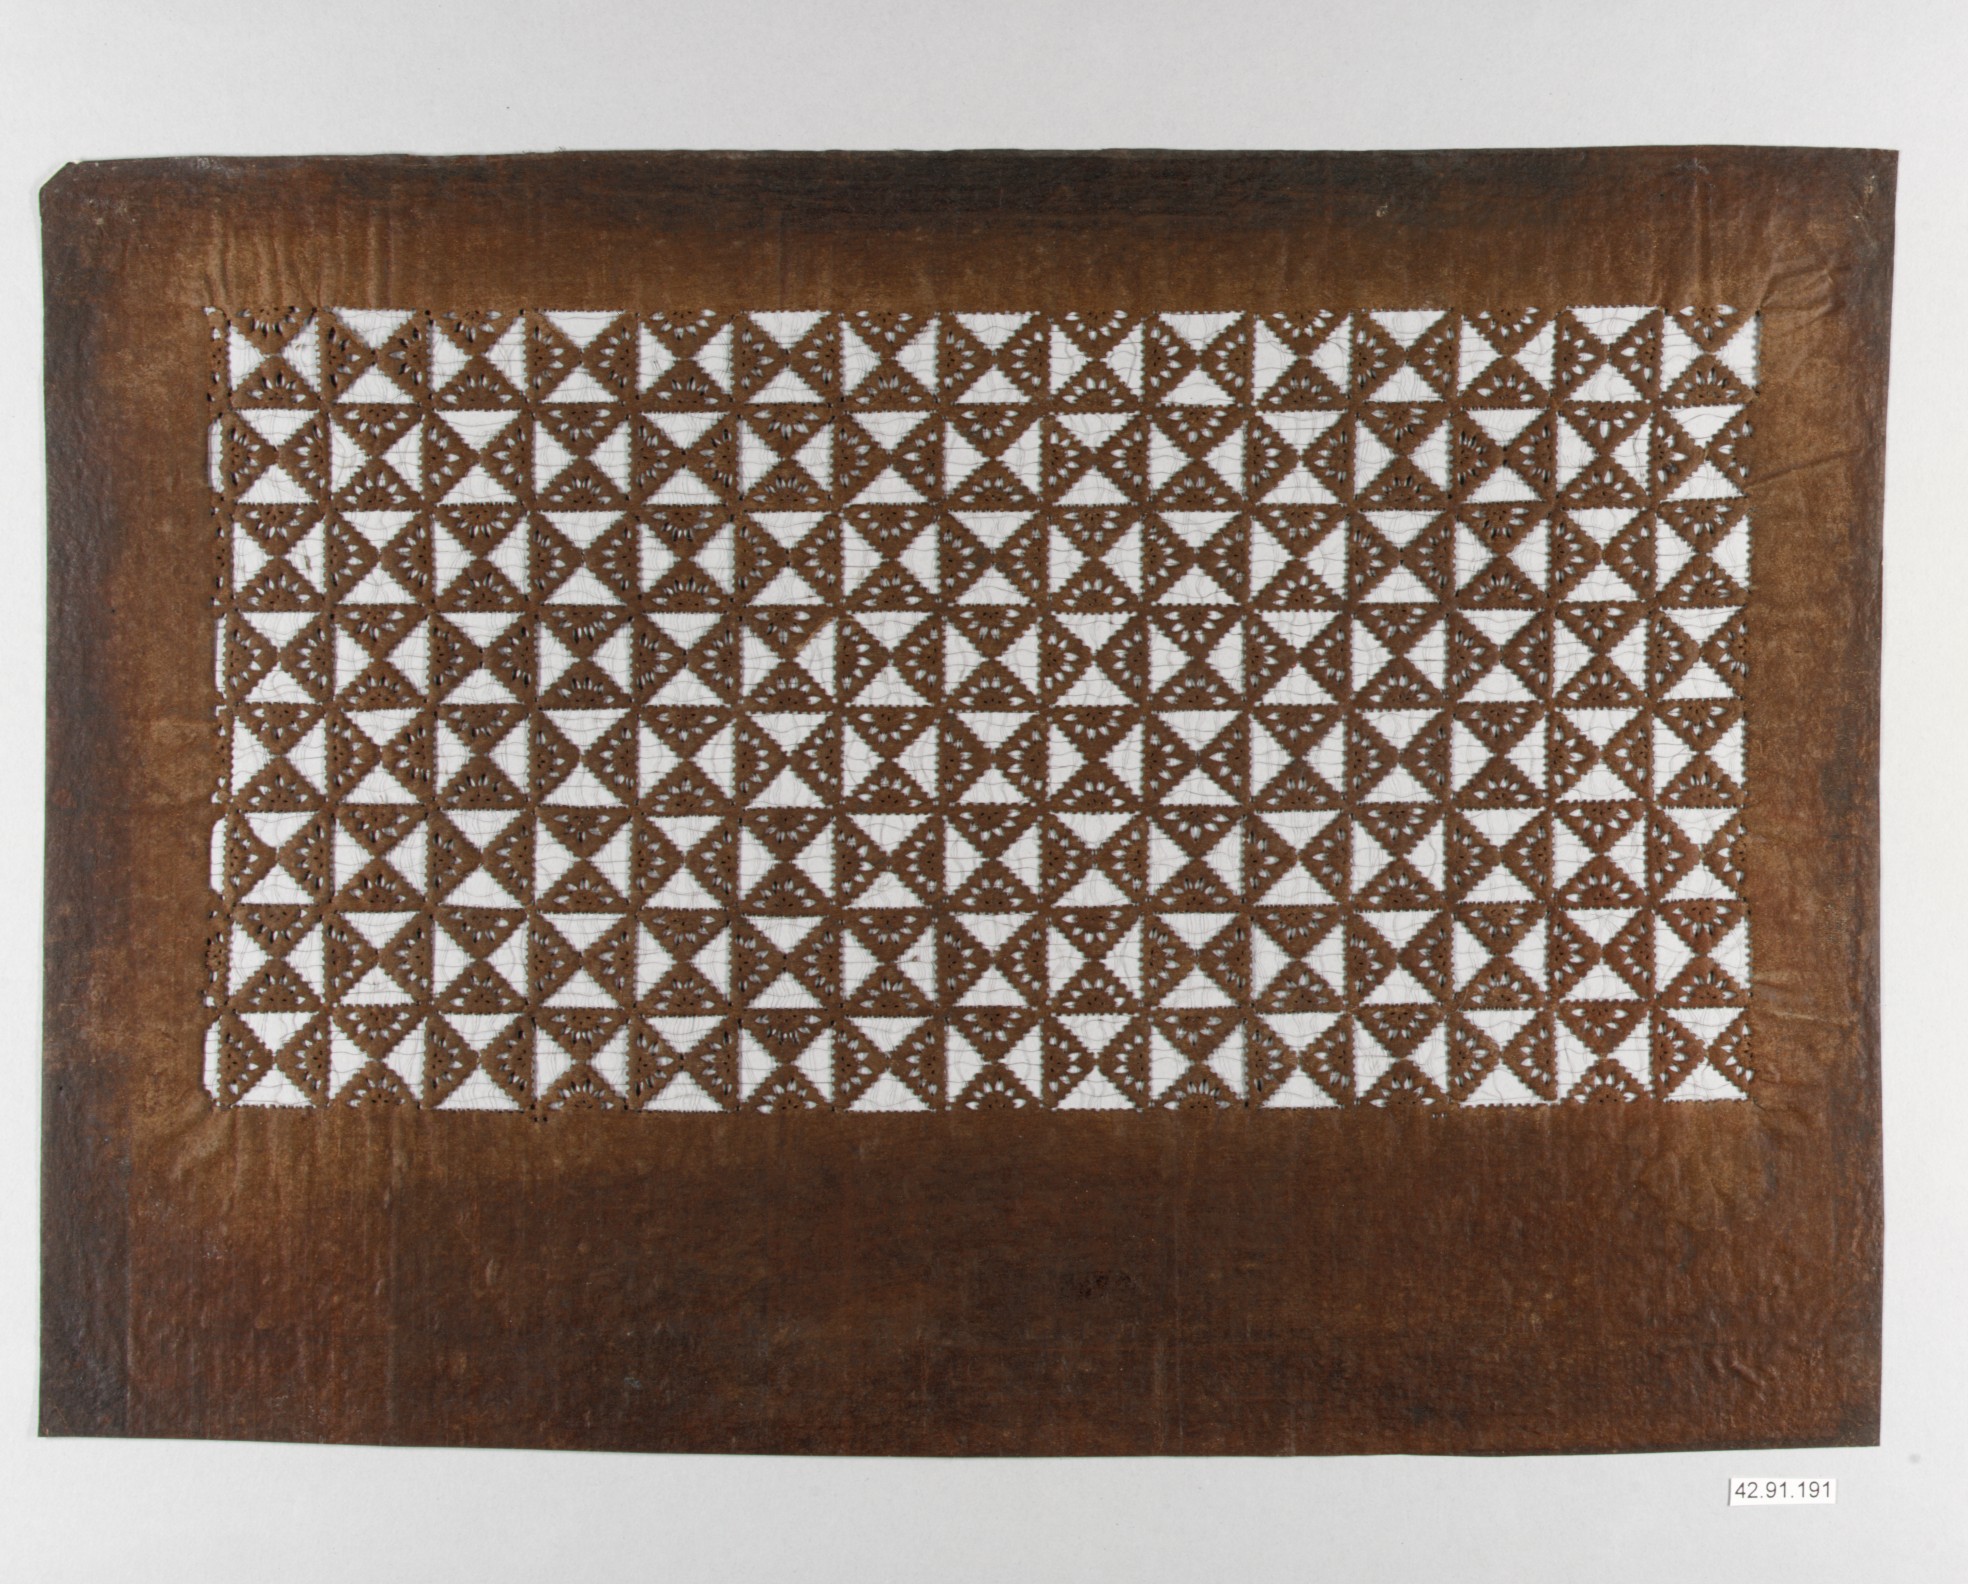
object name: stencil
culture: japanese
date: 1801-1900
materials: paper, silk